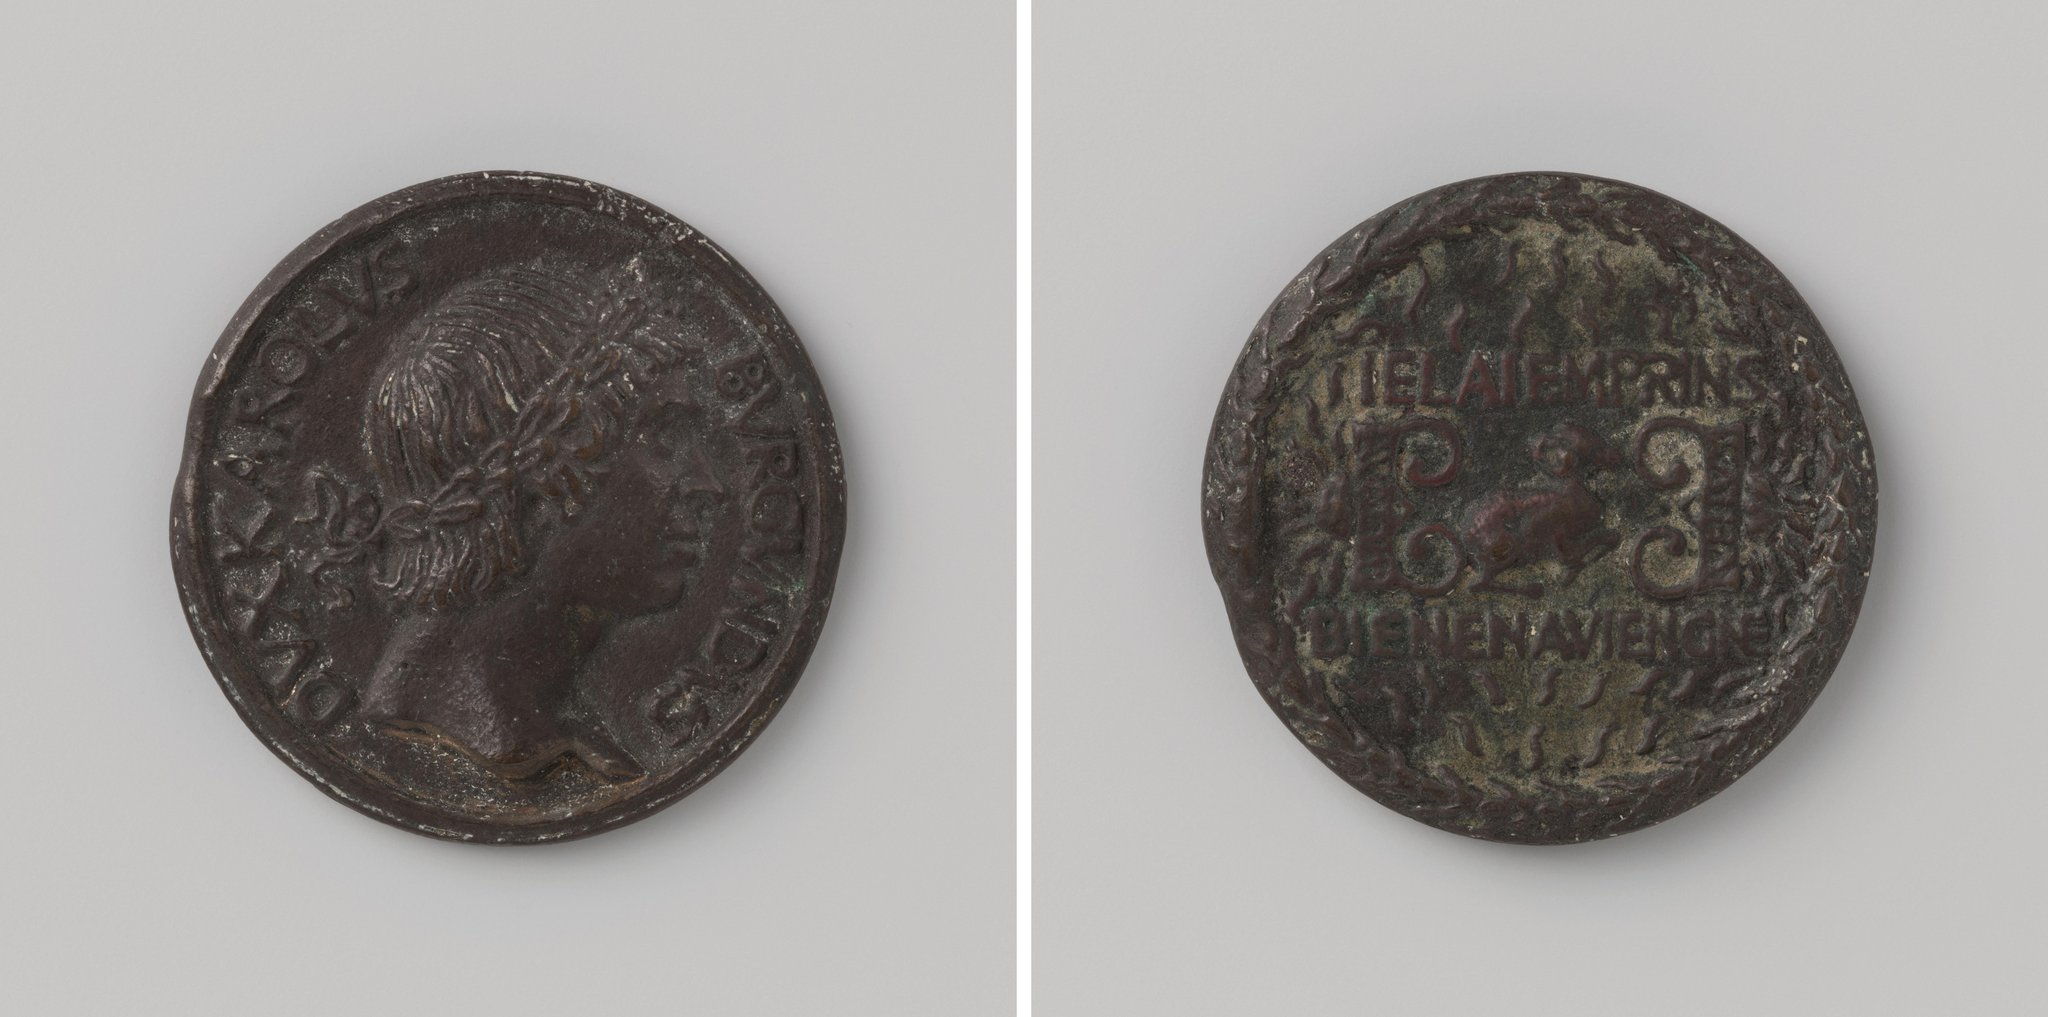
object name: copy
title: Karel de Stoute, hertog van Bourgondie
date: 1474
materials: bronze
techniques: casting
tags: earl, charles the bold (duke of burgundy)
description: Bronzen penning. Voorzijde: borststuk man met lauwerkrans binnen omschrift. Keerzijde: guldenvlies tussen opschriften, binnen lauwerkrans.